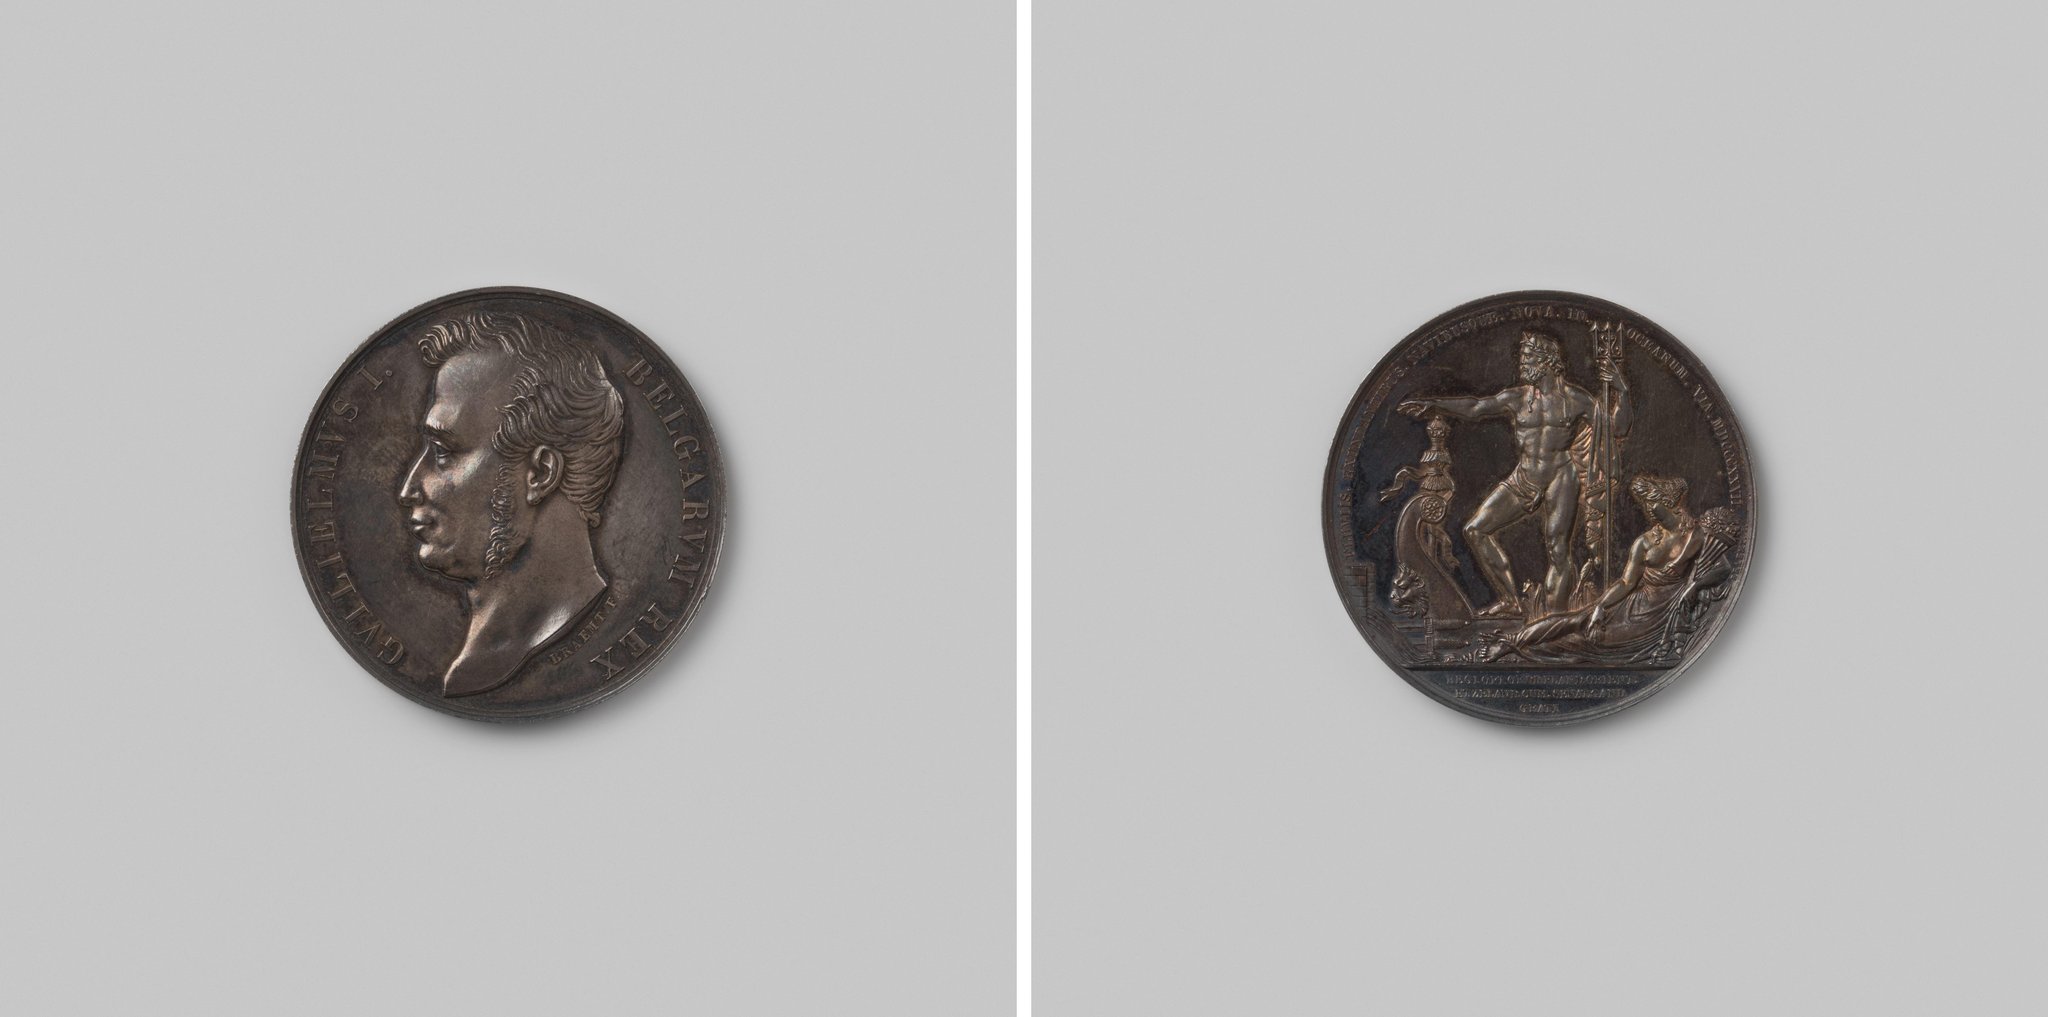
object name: history medal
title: Opening van het Kanaal van Terneuzen naar Gent 1827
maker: joseph pierre braemt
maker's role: print maker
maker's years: 1796-1864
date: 1827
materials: silver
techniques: striking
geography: brussels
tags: haarlem, the hague, berlin, william i of the netherlands, ghent